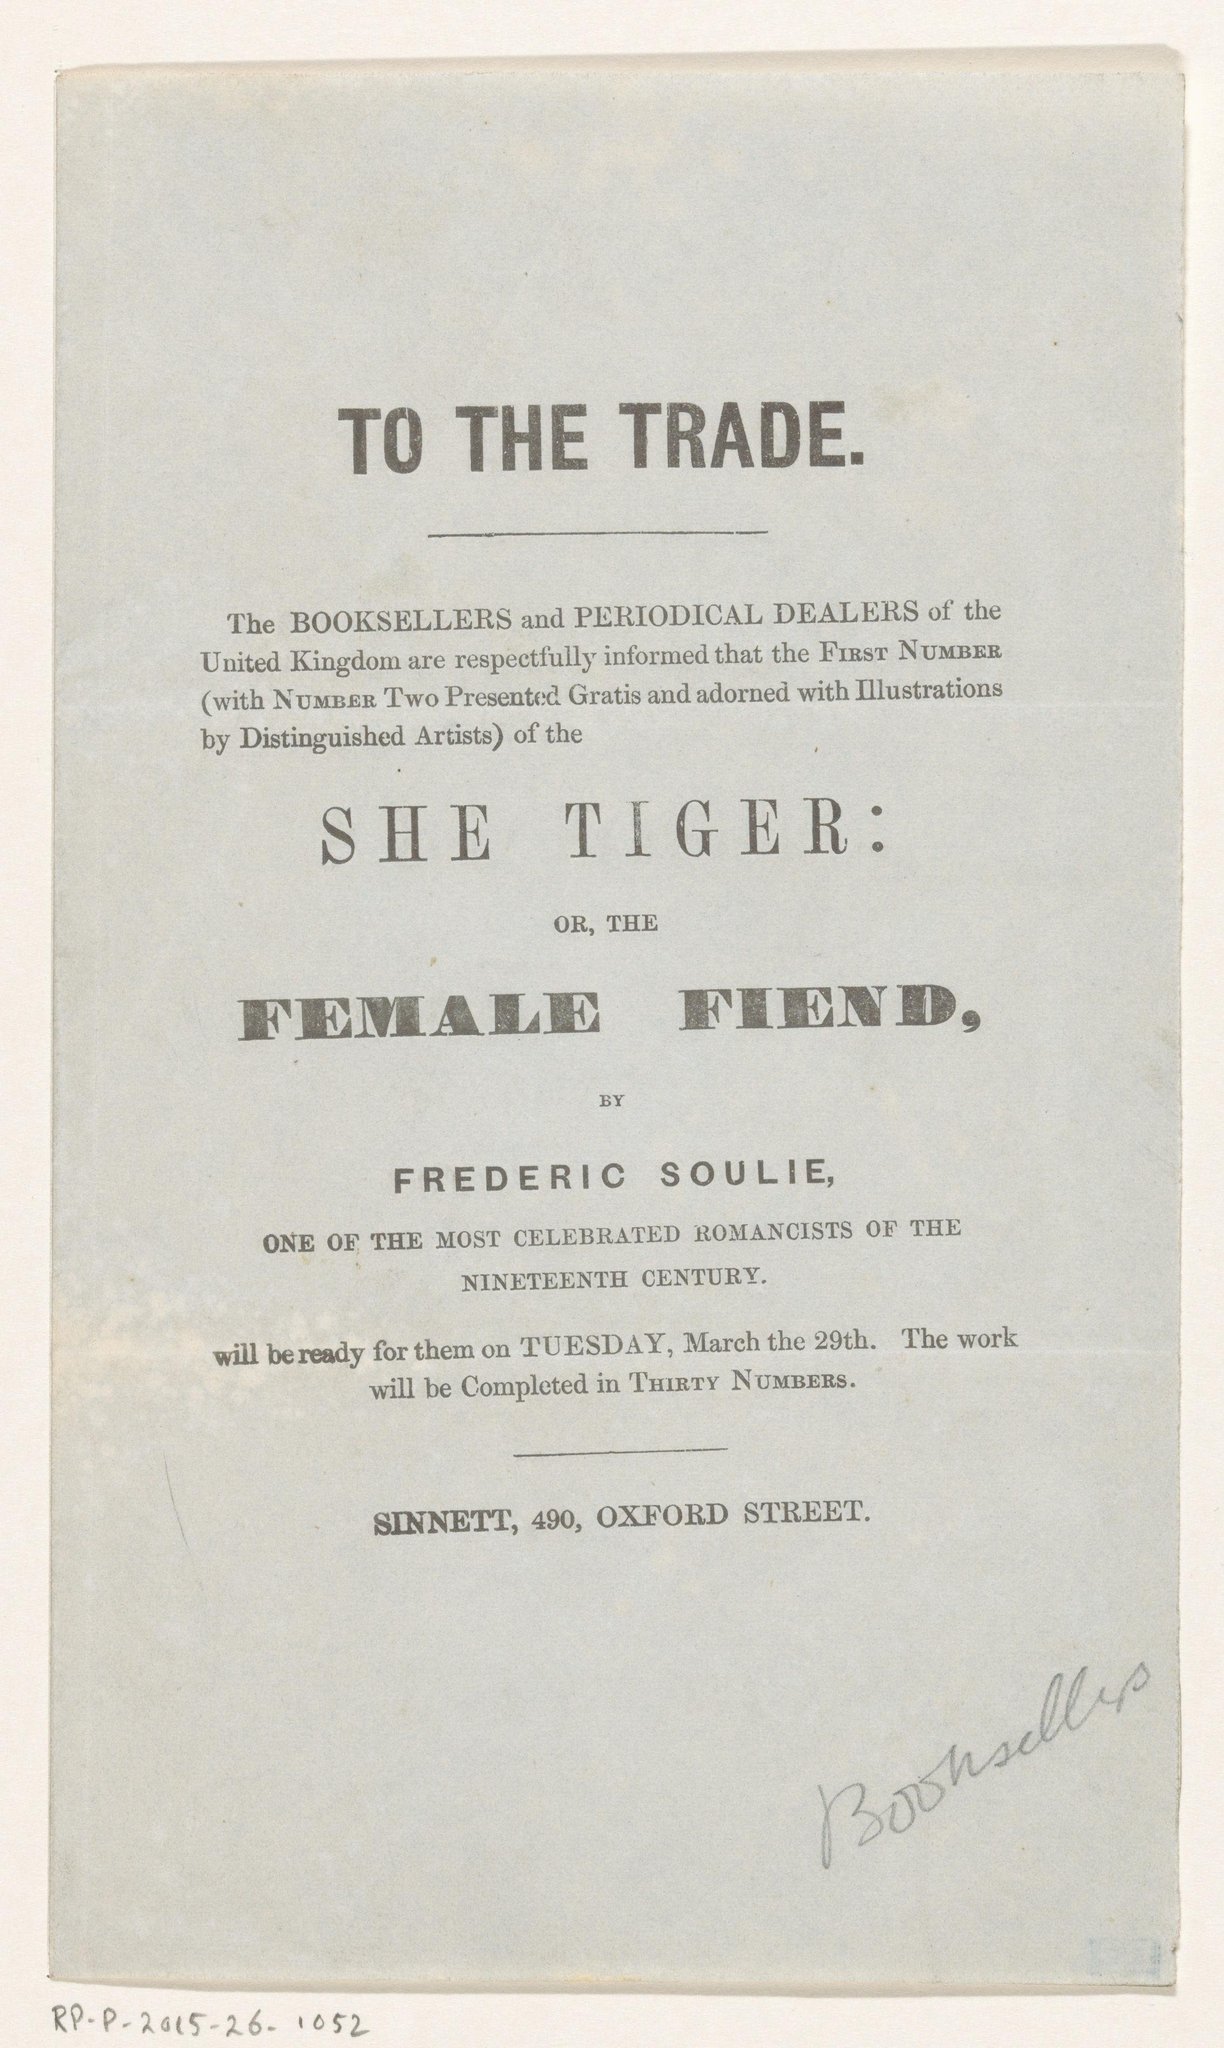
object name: print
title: Reclamefolder van uitgever John Taylor Sinnett te Londen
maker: john taylor sinnett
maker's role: publisher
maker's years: 1807-1880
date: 1853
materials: paper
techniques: printing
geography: london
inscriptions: collector's mark: Lugt 4780, collector's mark: Lugt 2228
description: Het betreft een Engelse vertaling van 'La Lionne' door Frédéric Soulié, uitgegeven in 1845.